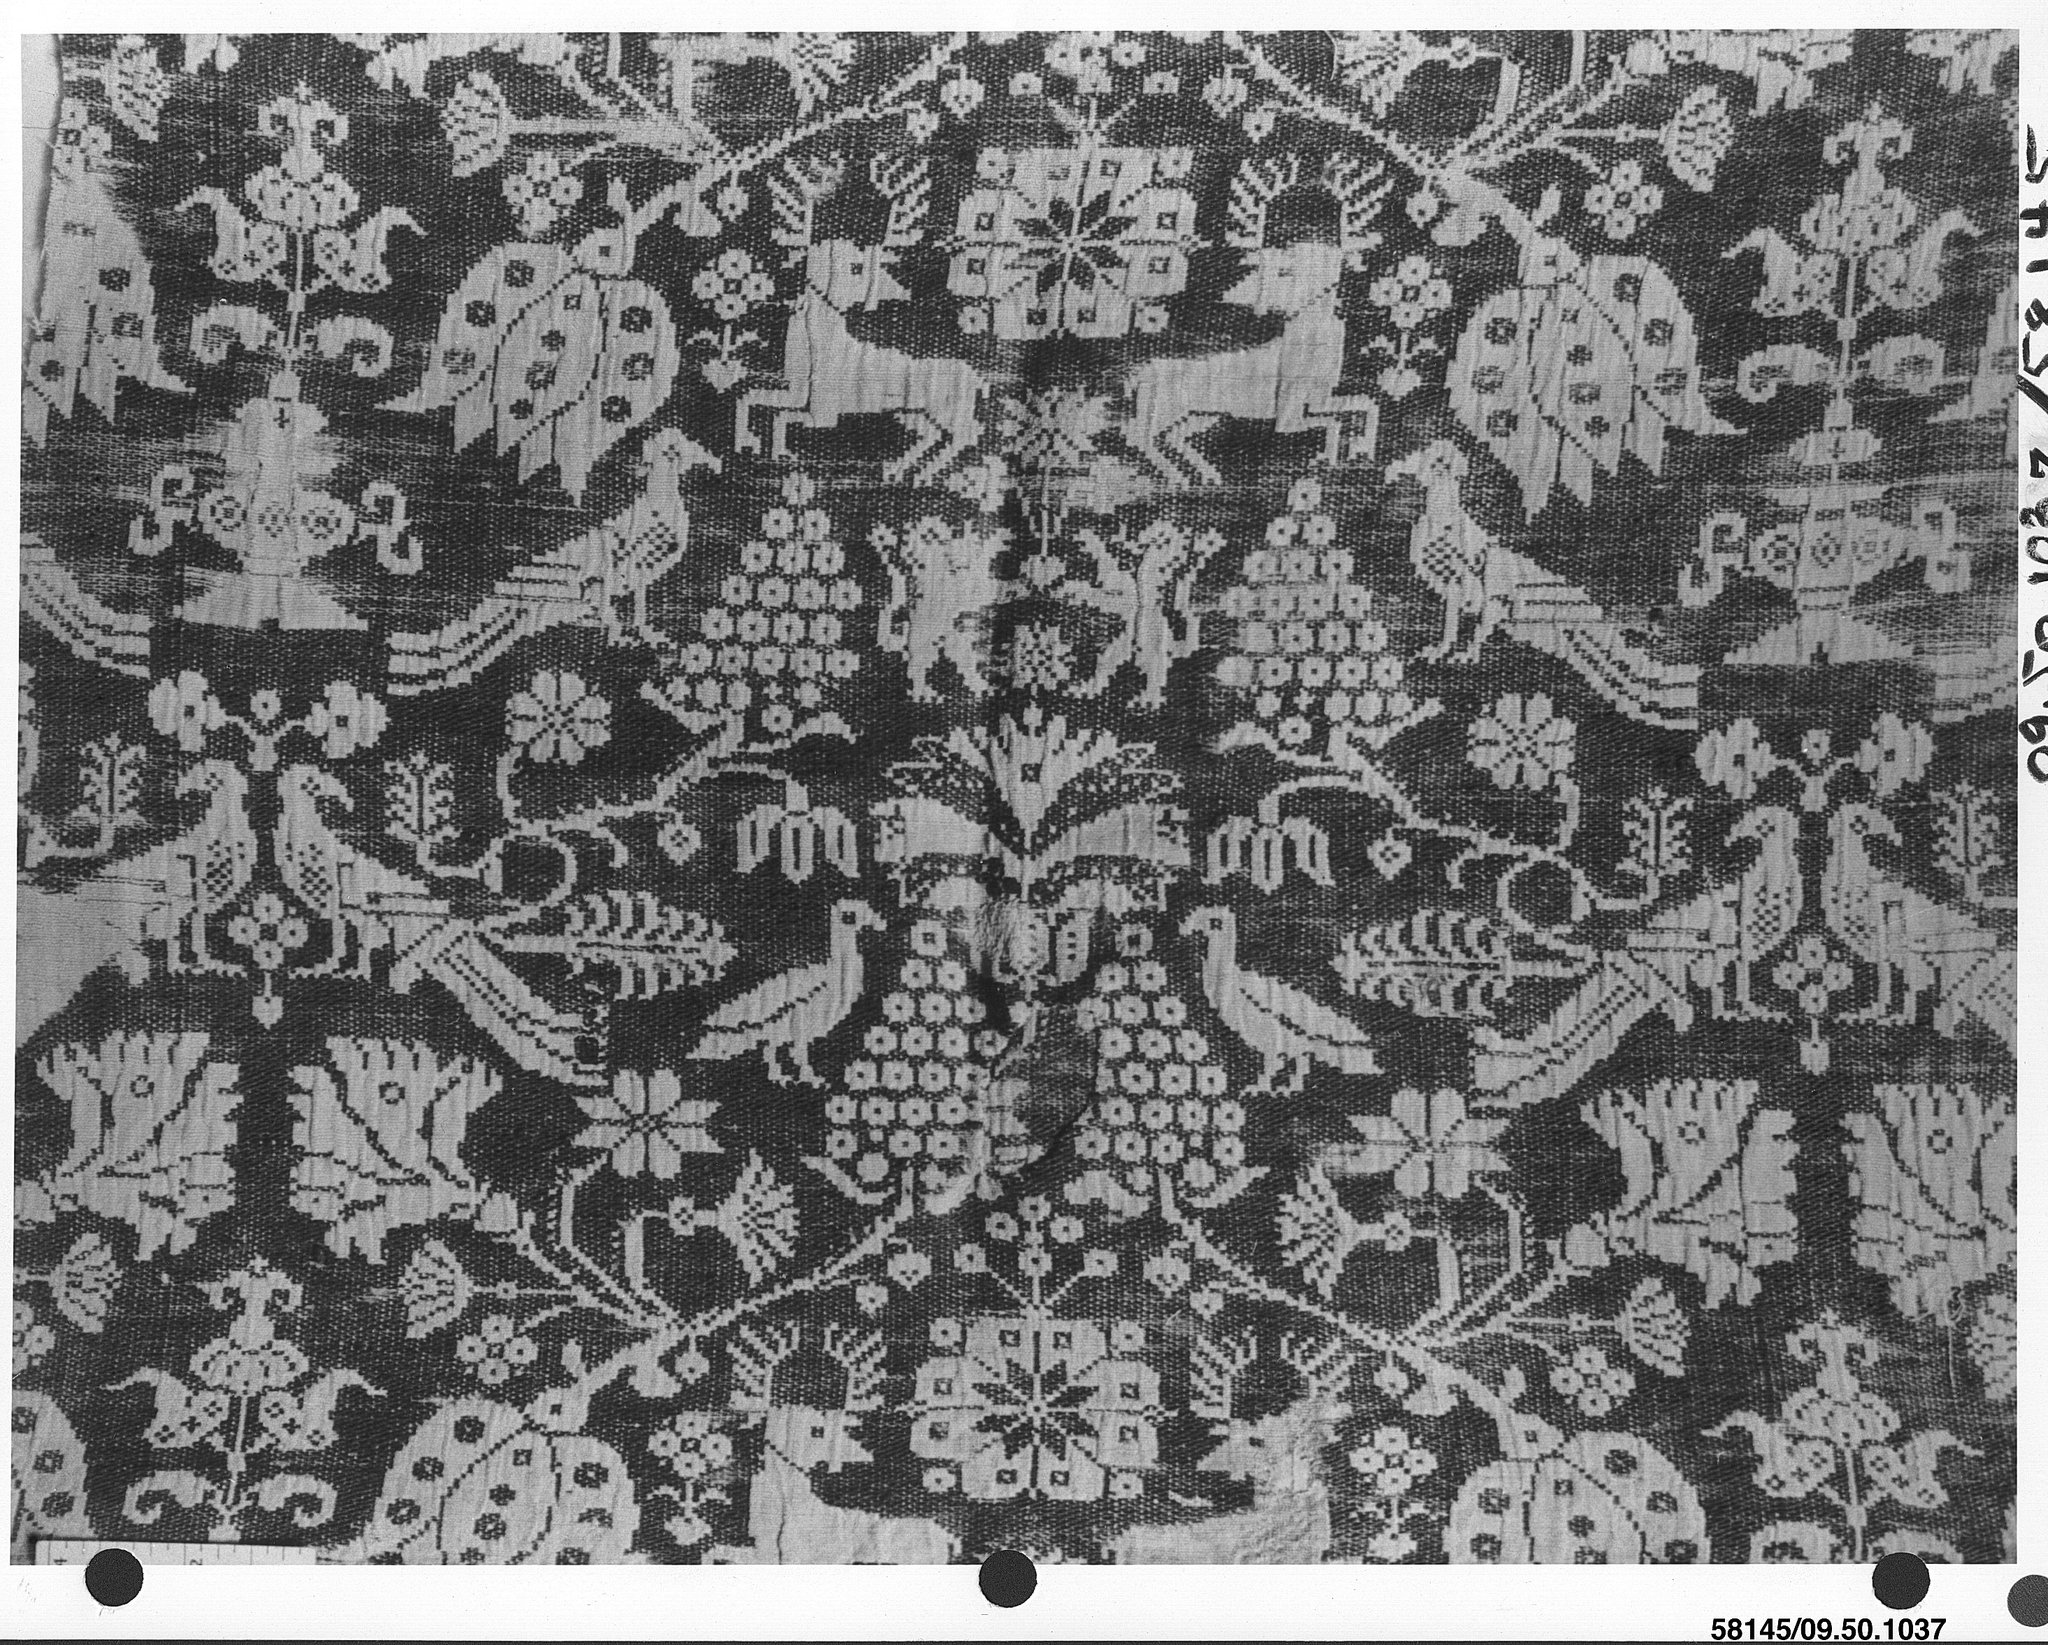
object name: piece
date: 1701-1800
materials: linen, wool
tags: birds,peacocks,deer,flowers